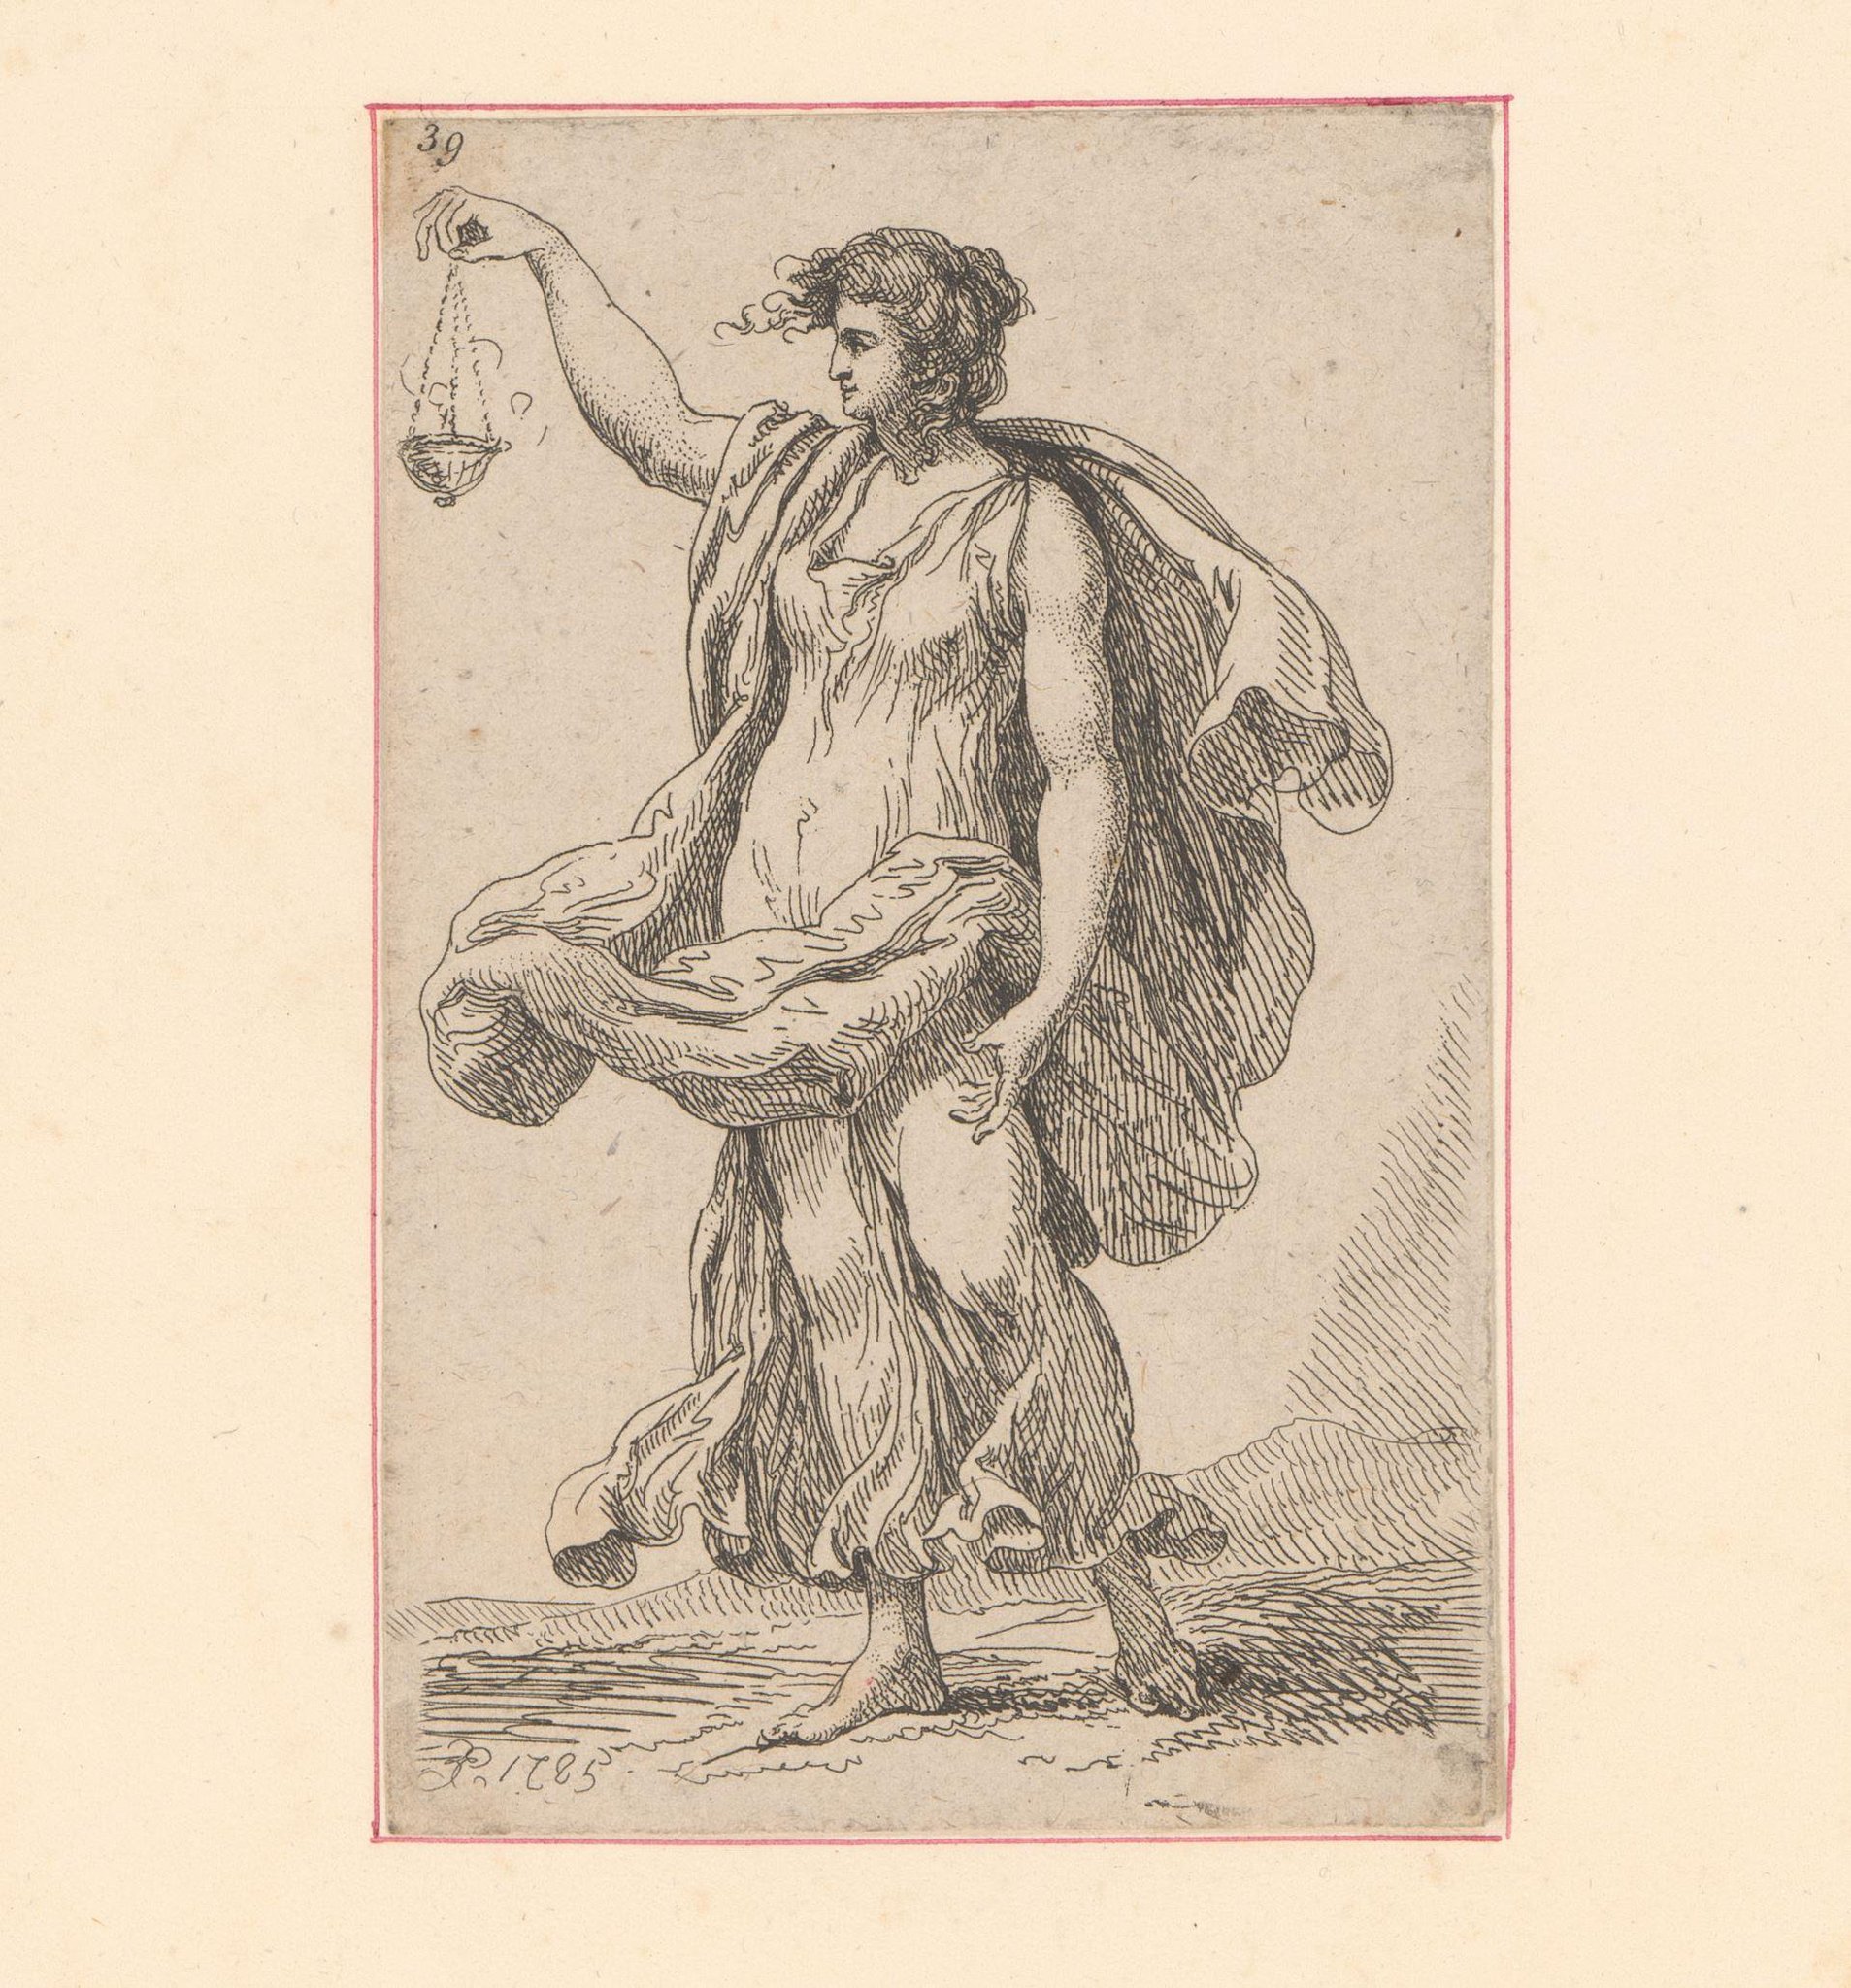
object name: print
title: Vrouw met wierookbrander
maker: edward edwards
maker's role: painter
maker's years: 1738-1806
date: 1785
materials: paper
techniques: etching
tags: standing figure - aa - female human figure, incense-burner ~ scents, perfumes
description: Prent maakt deel uit van een serie van 51 prenten, bestaande uit twee delen met landschappen (36 prenten) en figuren en portretten (15 prenten), voor het eerst uitgegeven in Londen in 1790.